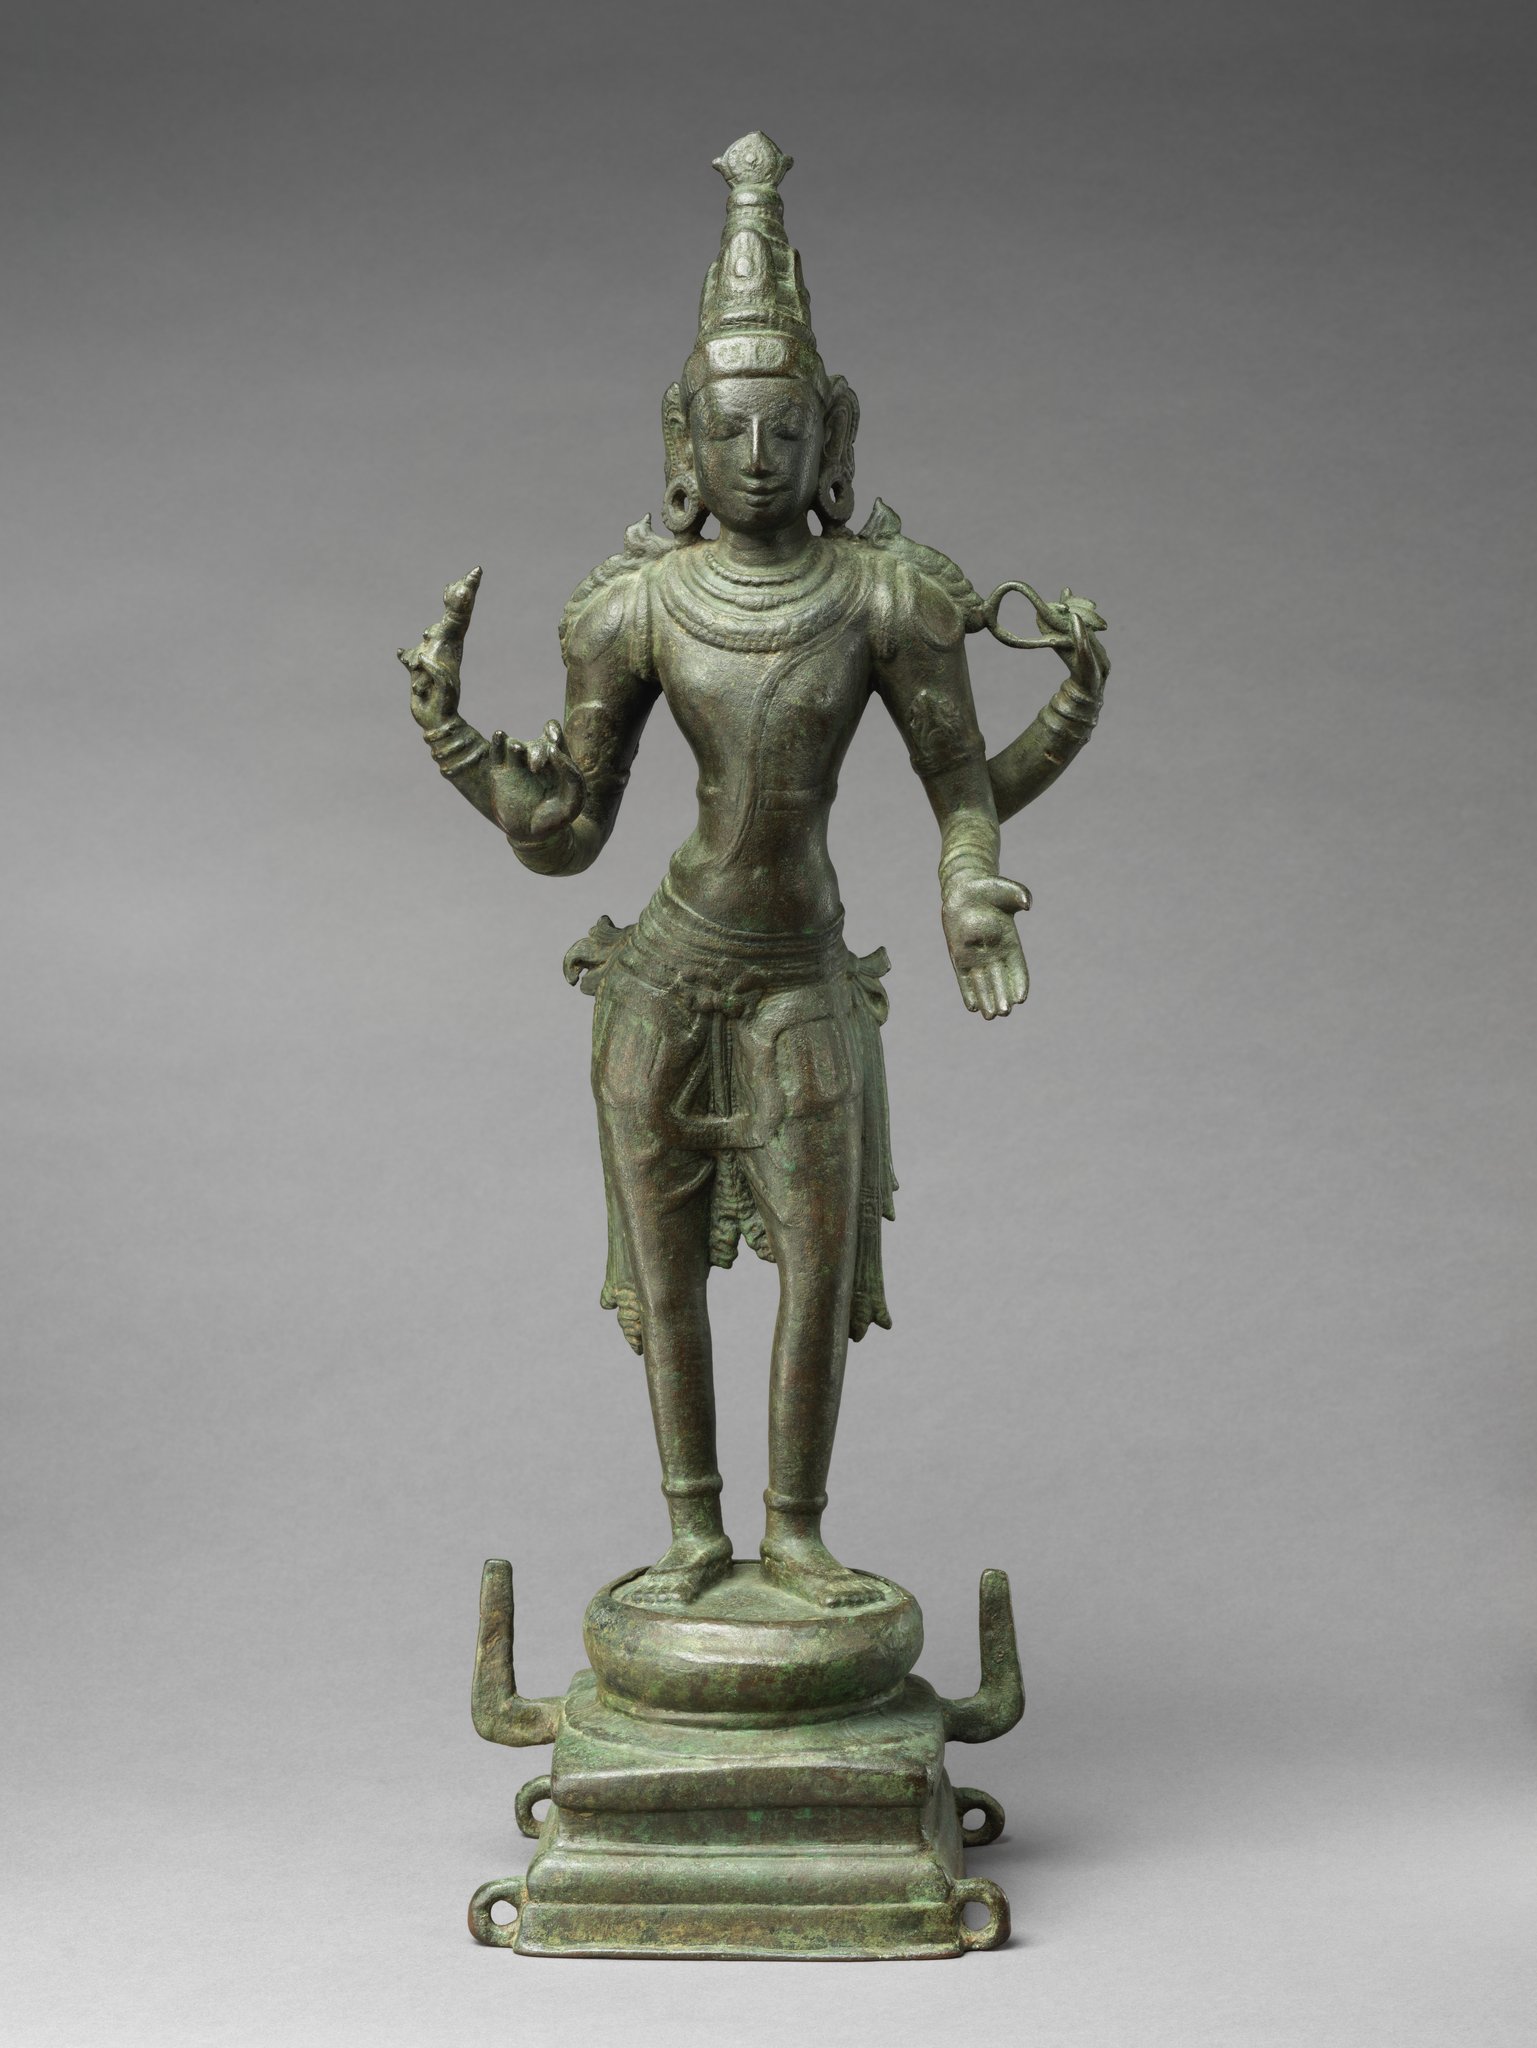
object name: figure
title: Chakra-Purusha, the Personified Discus Weapon of Vishnu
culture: tamil nadu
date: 901-1033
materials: copper alloy